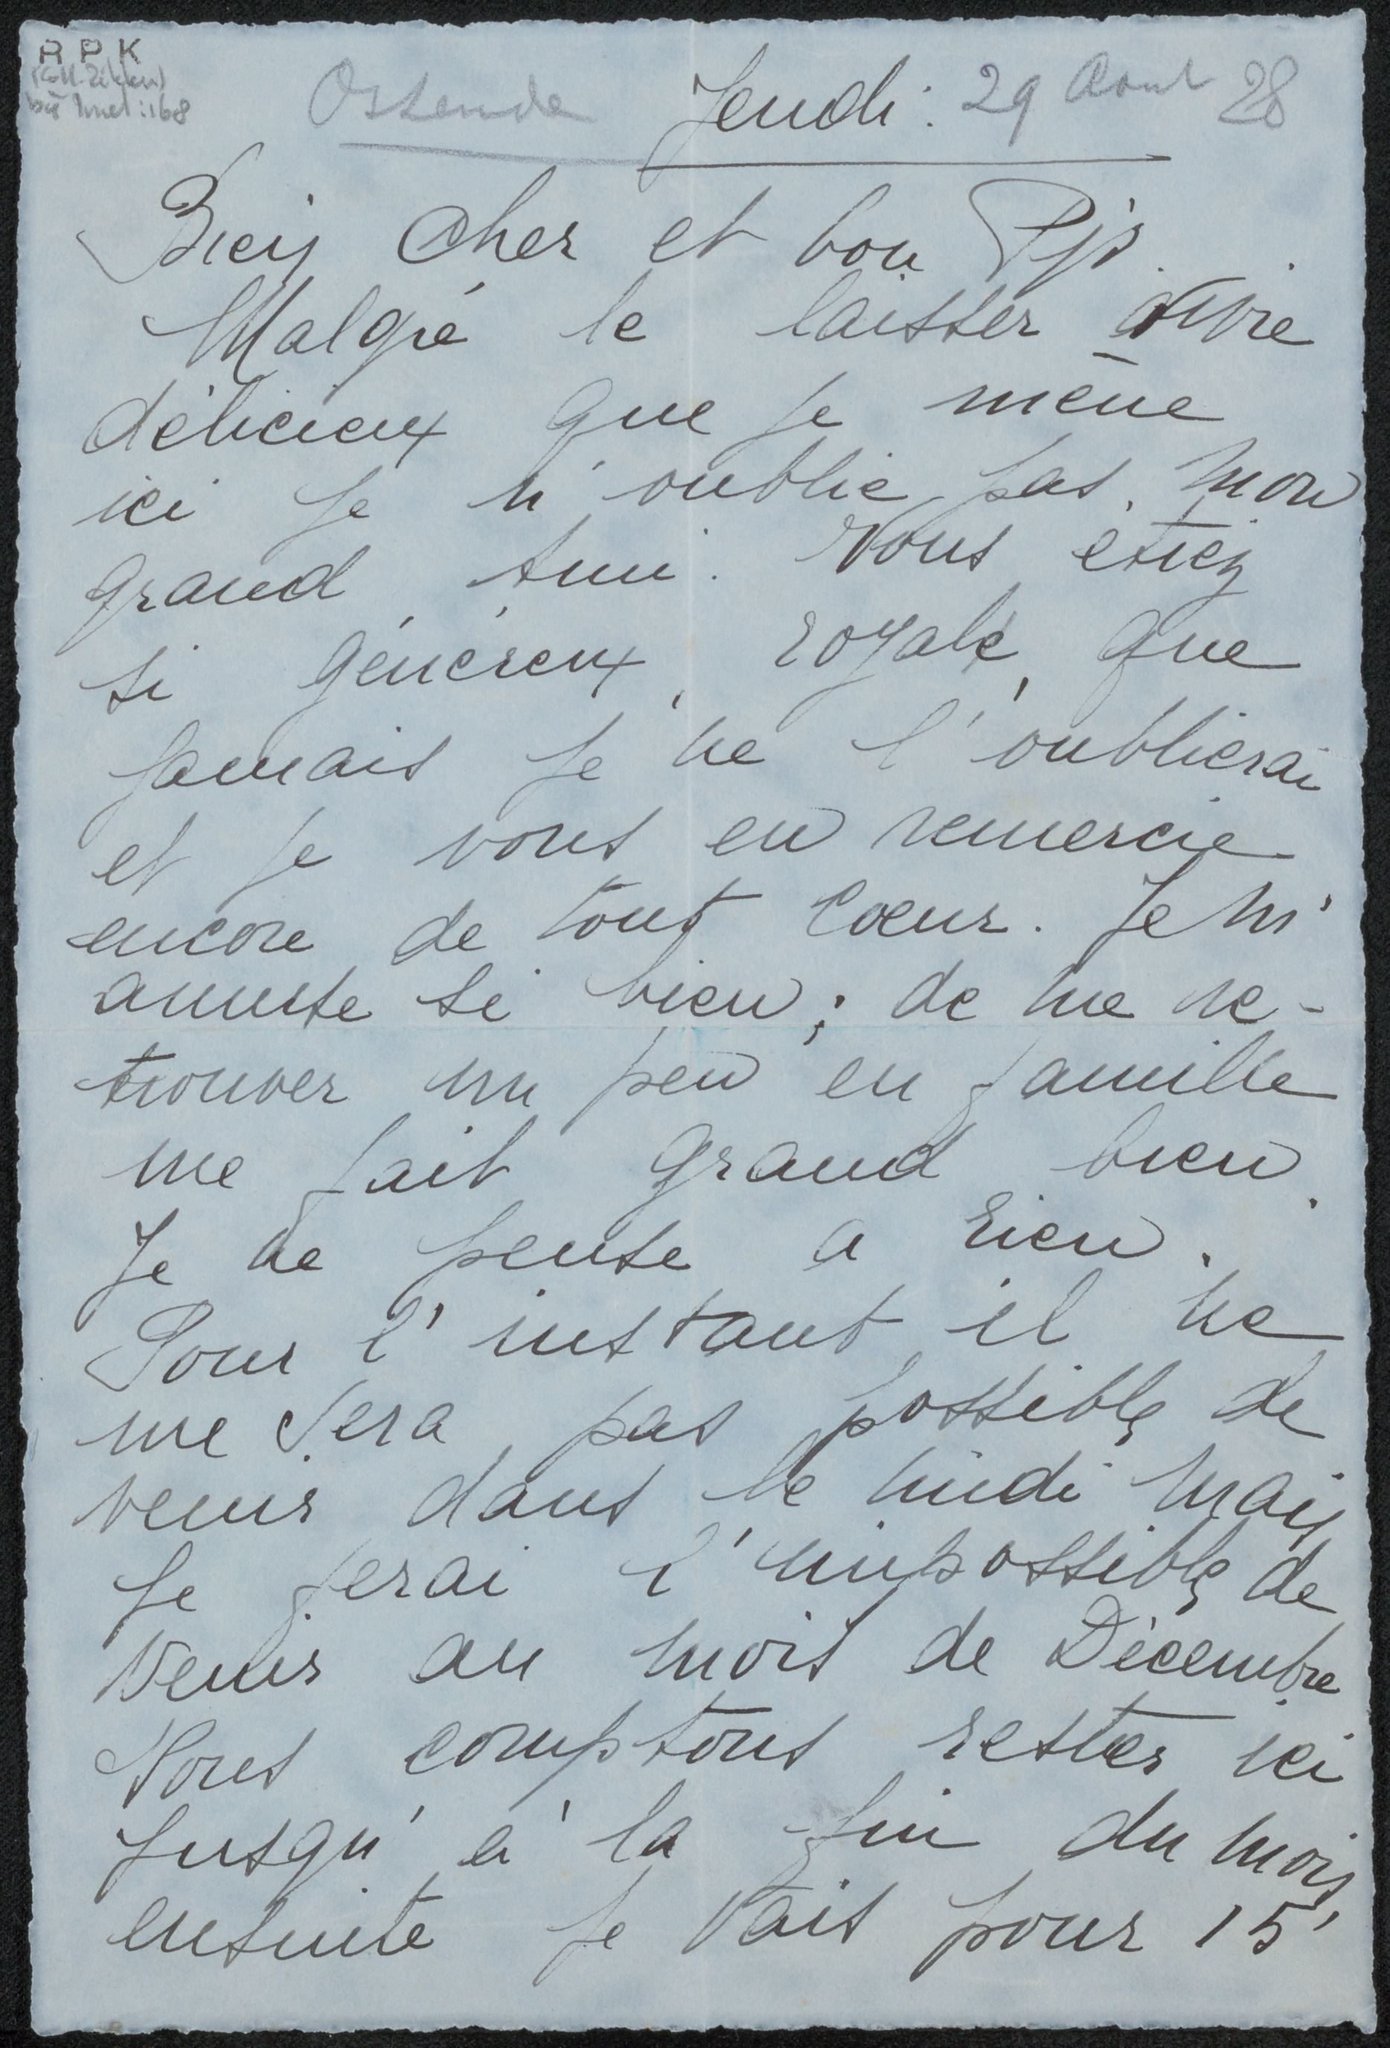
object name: letter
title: Brief aan Philip Zilcken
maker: rose imel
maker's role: draughtsman, painter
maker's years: 1901-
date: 1911-1930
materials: ink, paper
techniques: pen, writing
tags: the hague, painter, philip zilcken, education, tuition of the artist (in general), antwerp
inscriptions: collector's mark: ‘RPK’